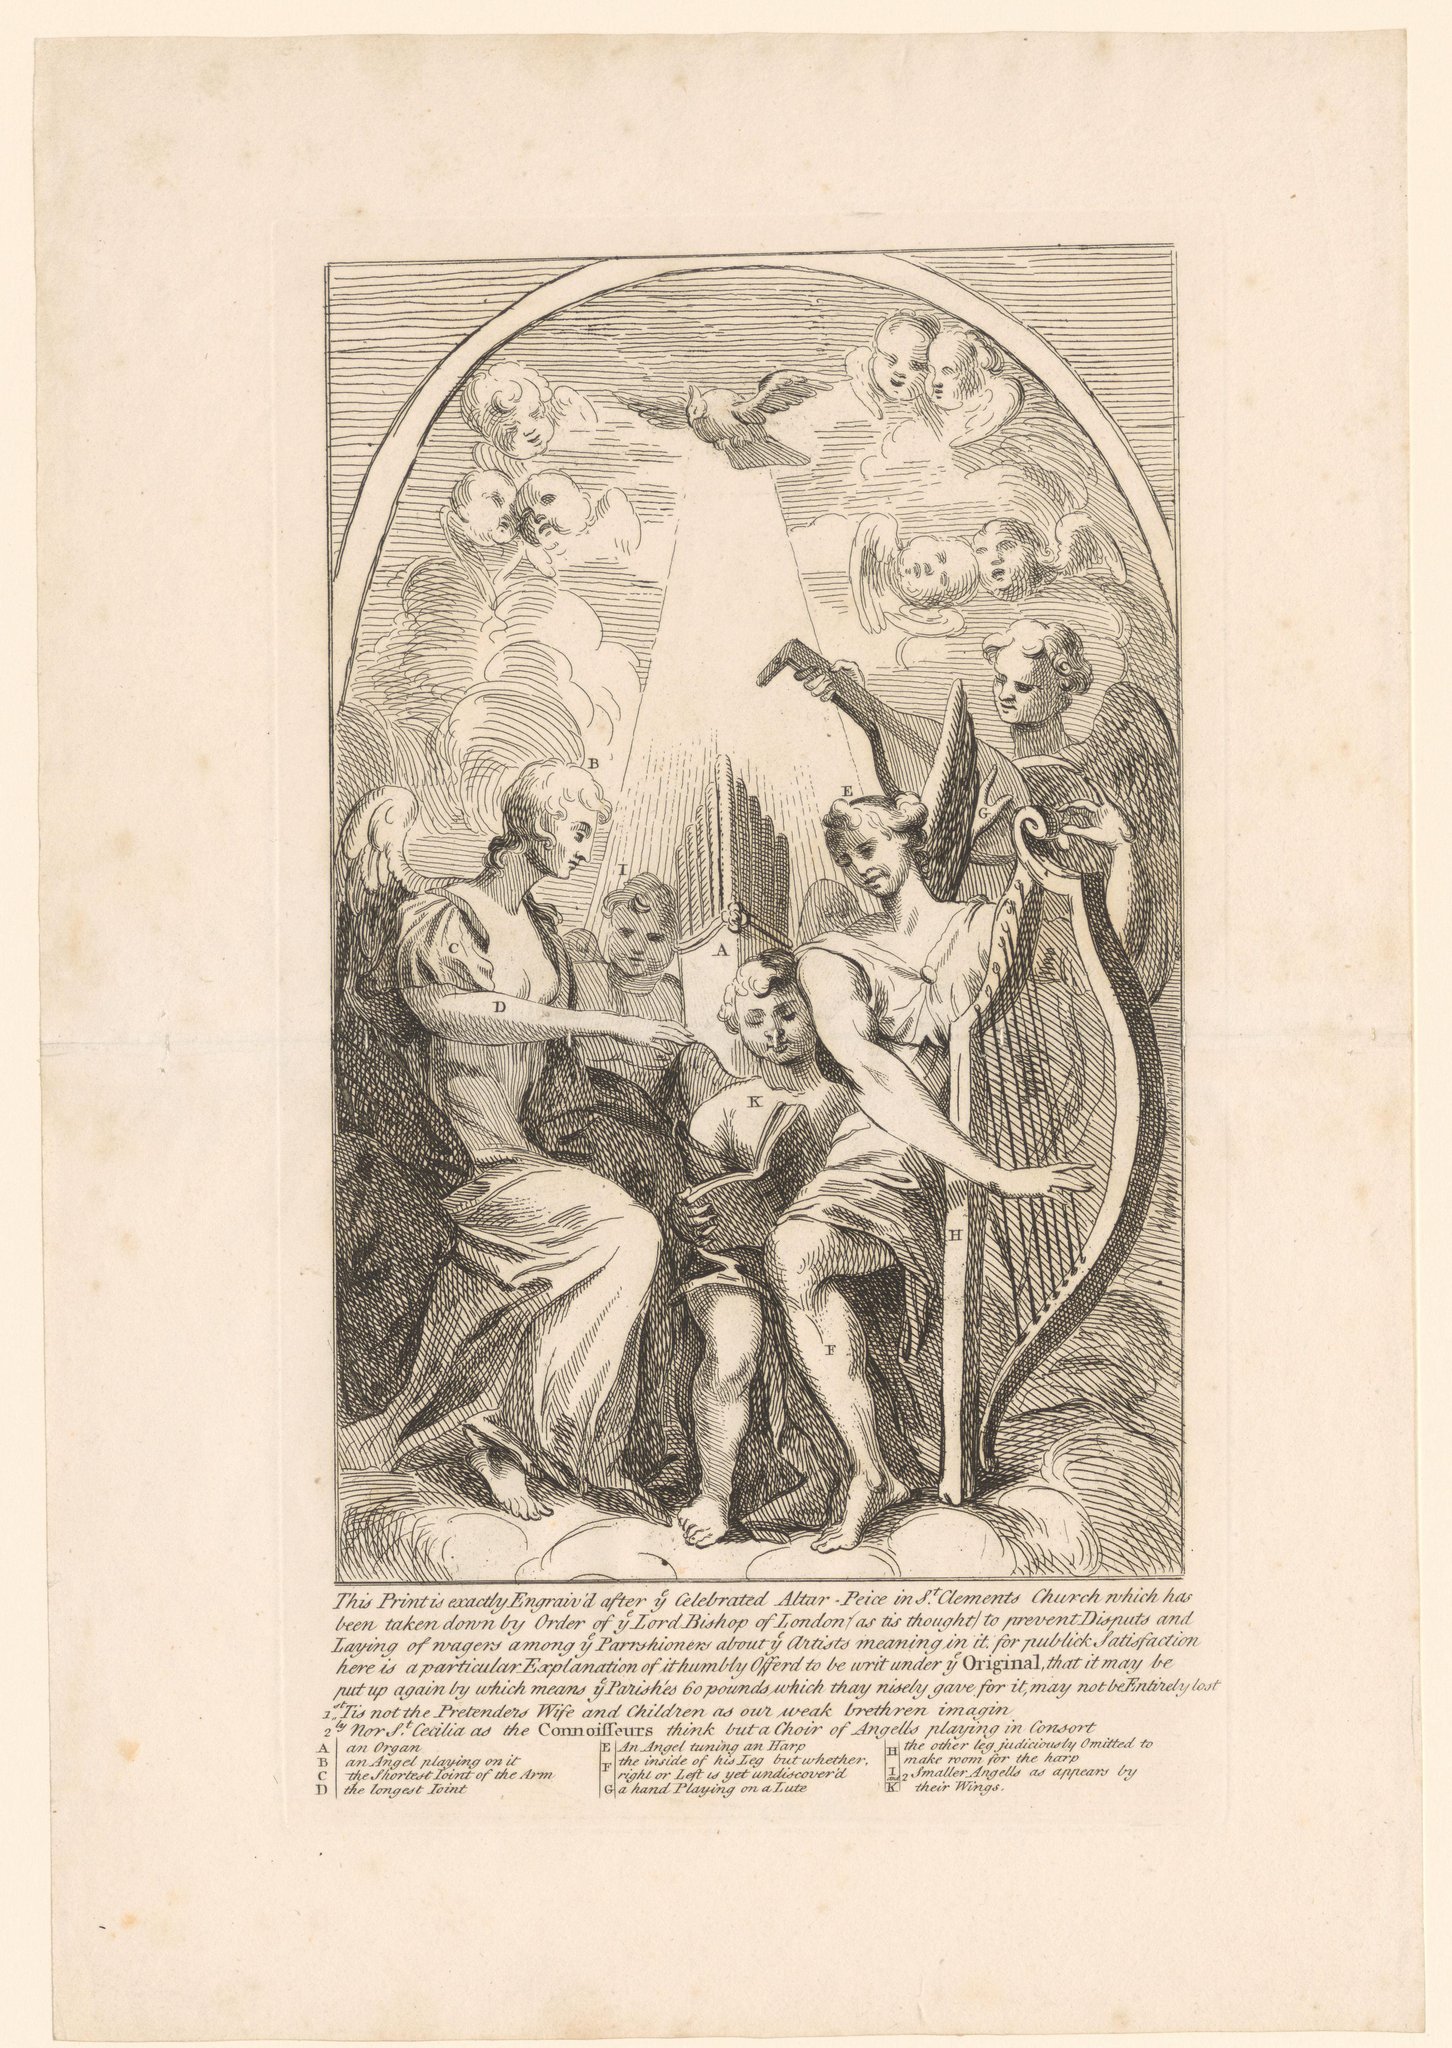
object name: print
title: Engelen met muziekinstrumenten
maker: william hogarth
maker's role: draughtsman, painter, print maker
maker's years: 1697-1764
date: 1725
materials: paper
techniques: etching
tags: angels singing, making music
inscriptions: collector's mark: Lugt 2228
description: Deze prent is gemaakt naar een altaarstuk in de St Clement Danes in Londen.